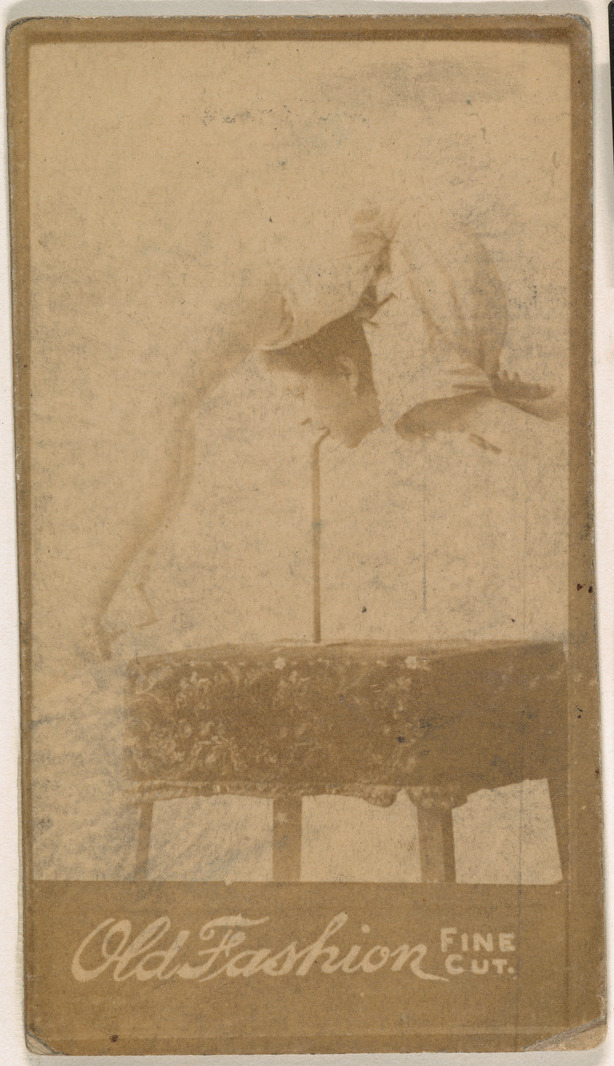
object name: photograph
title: Acrobat, from the Actresses series (N664) promoting Old Fashion Fine Cut Tobacco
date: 1888-1890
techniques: albumen silver print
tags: portraits,women,acrobats